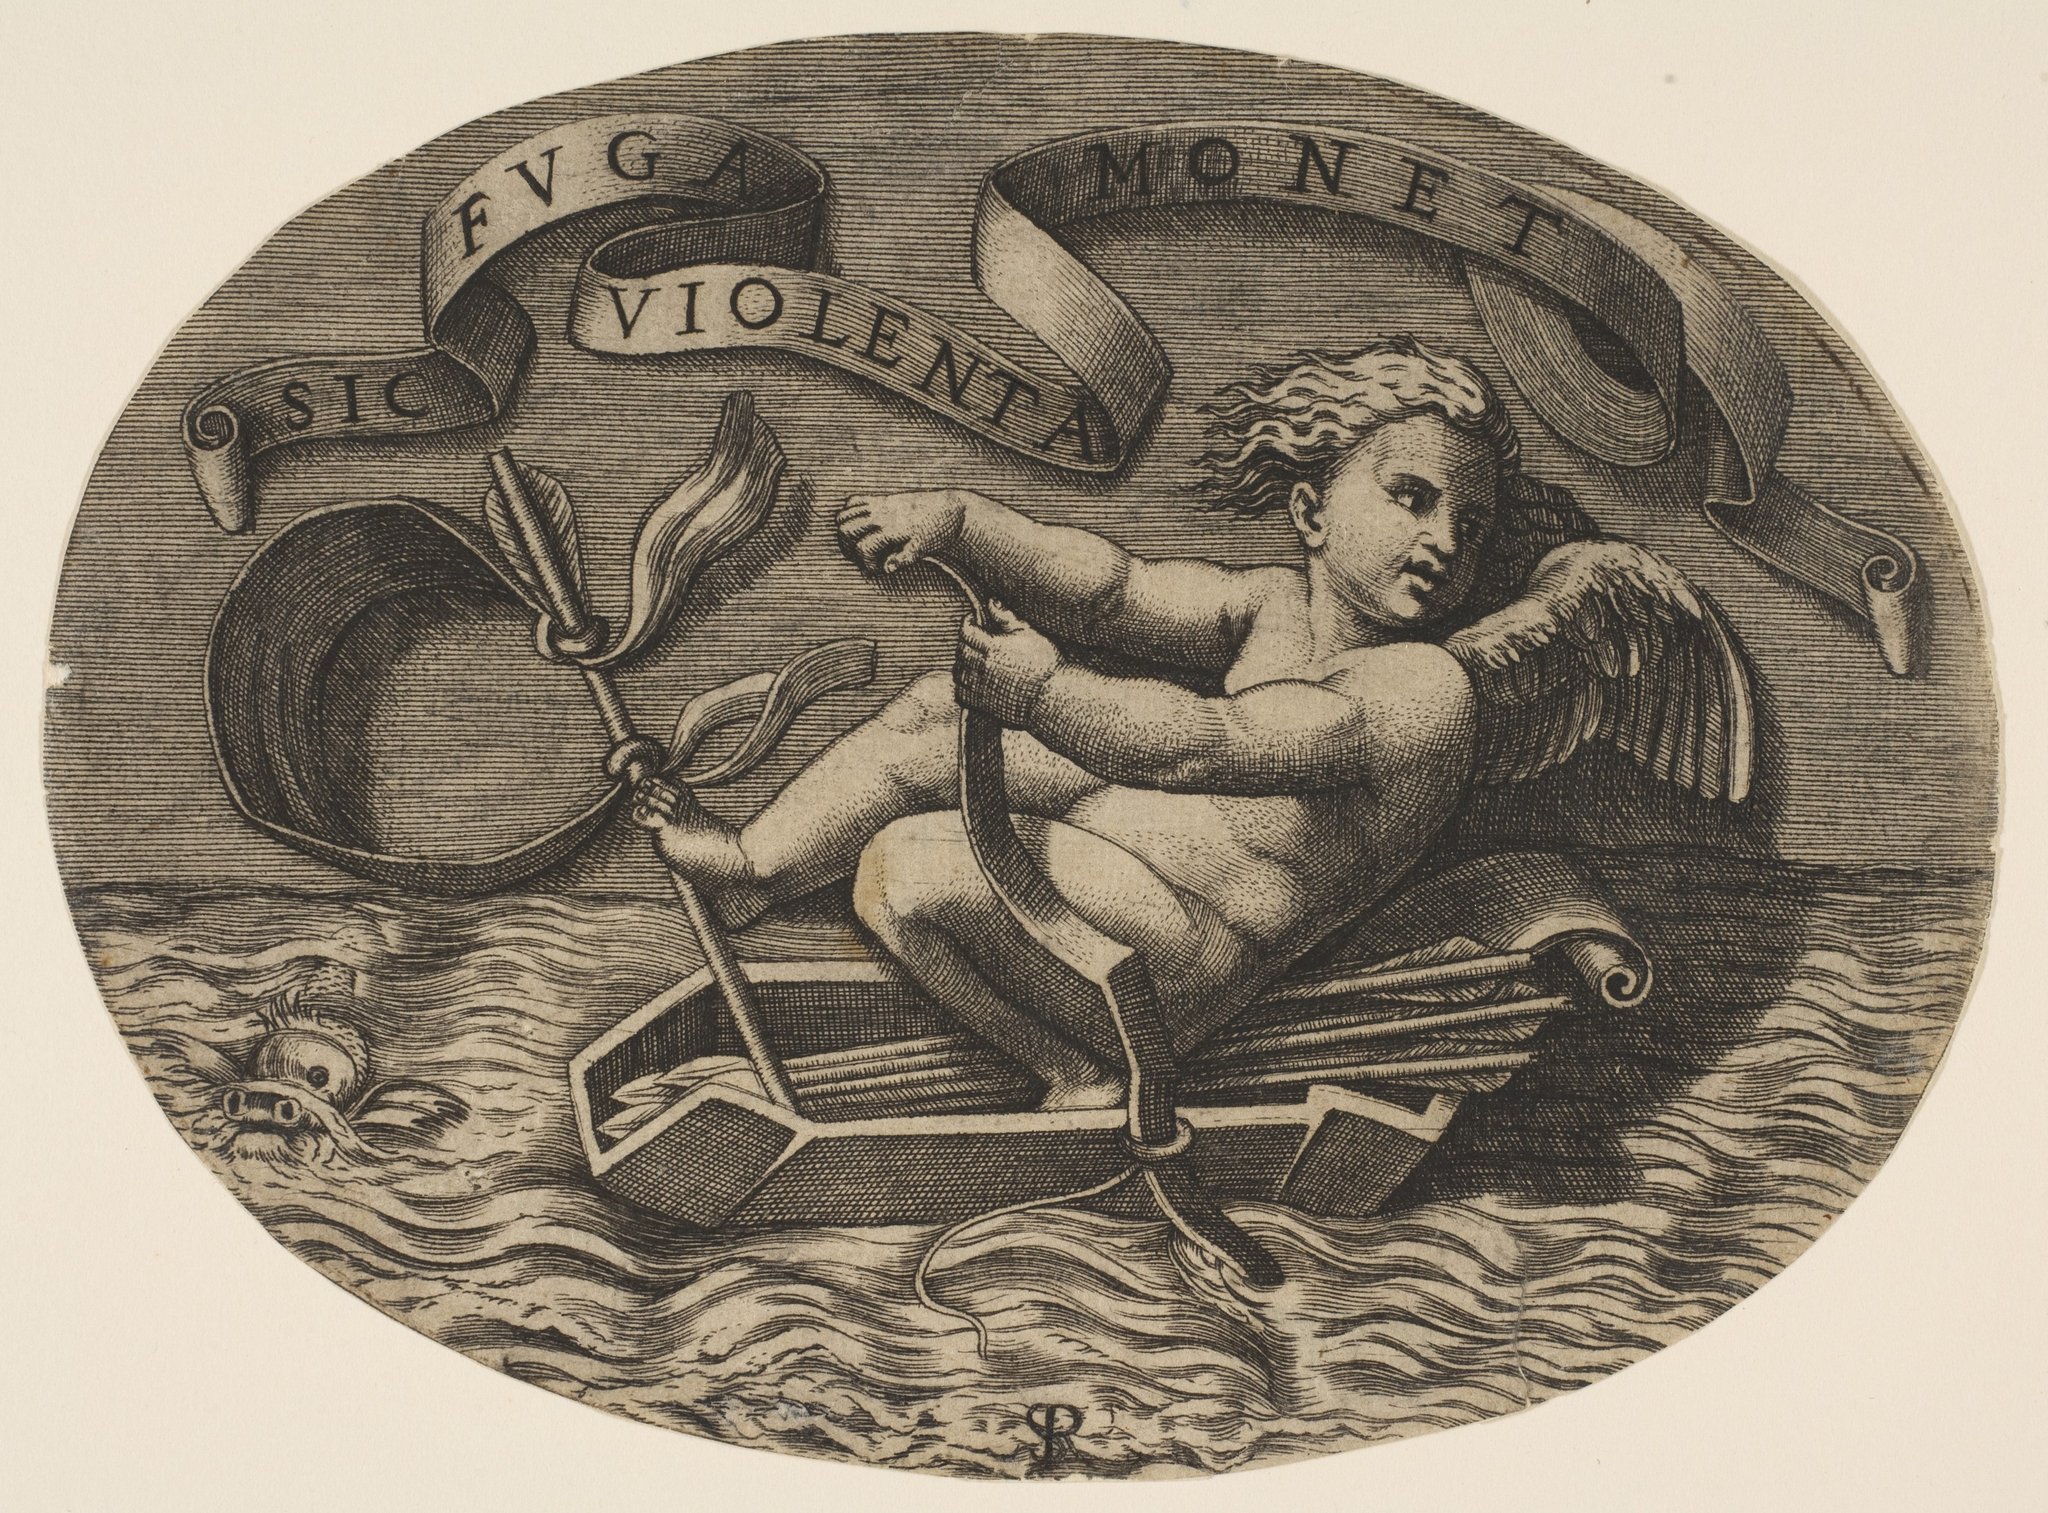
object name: print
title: Eros escaping by sea using his bow to propel a boat made from his quiver with an arrow as the mast and his blindfold as the sail, a banderole above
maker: marco dente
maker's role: artist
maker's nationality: italian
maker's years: 1515-1527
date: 1515-1527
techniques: engraving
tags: bow and arrow,eros,boats